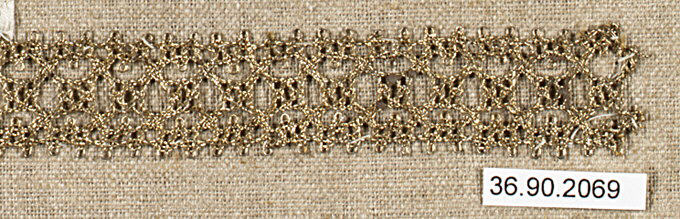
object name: piece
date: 1701-1800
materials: metal thread, silk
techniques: lace